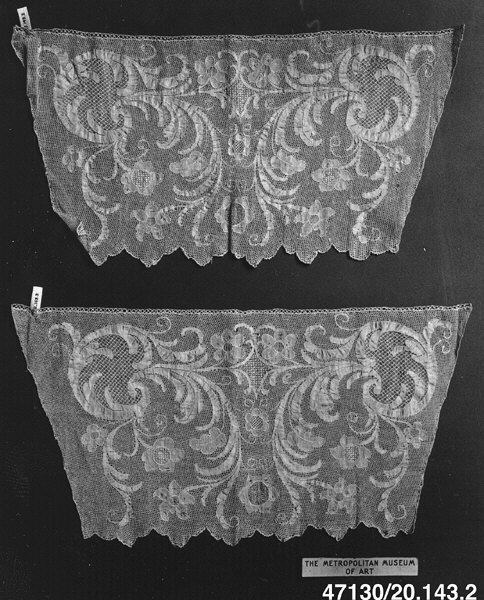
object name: cuff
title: Cuffs (one of a pair)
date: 1701-1800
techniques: embroidery